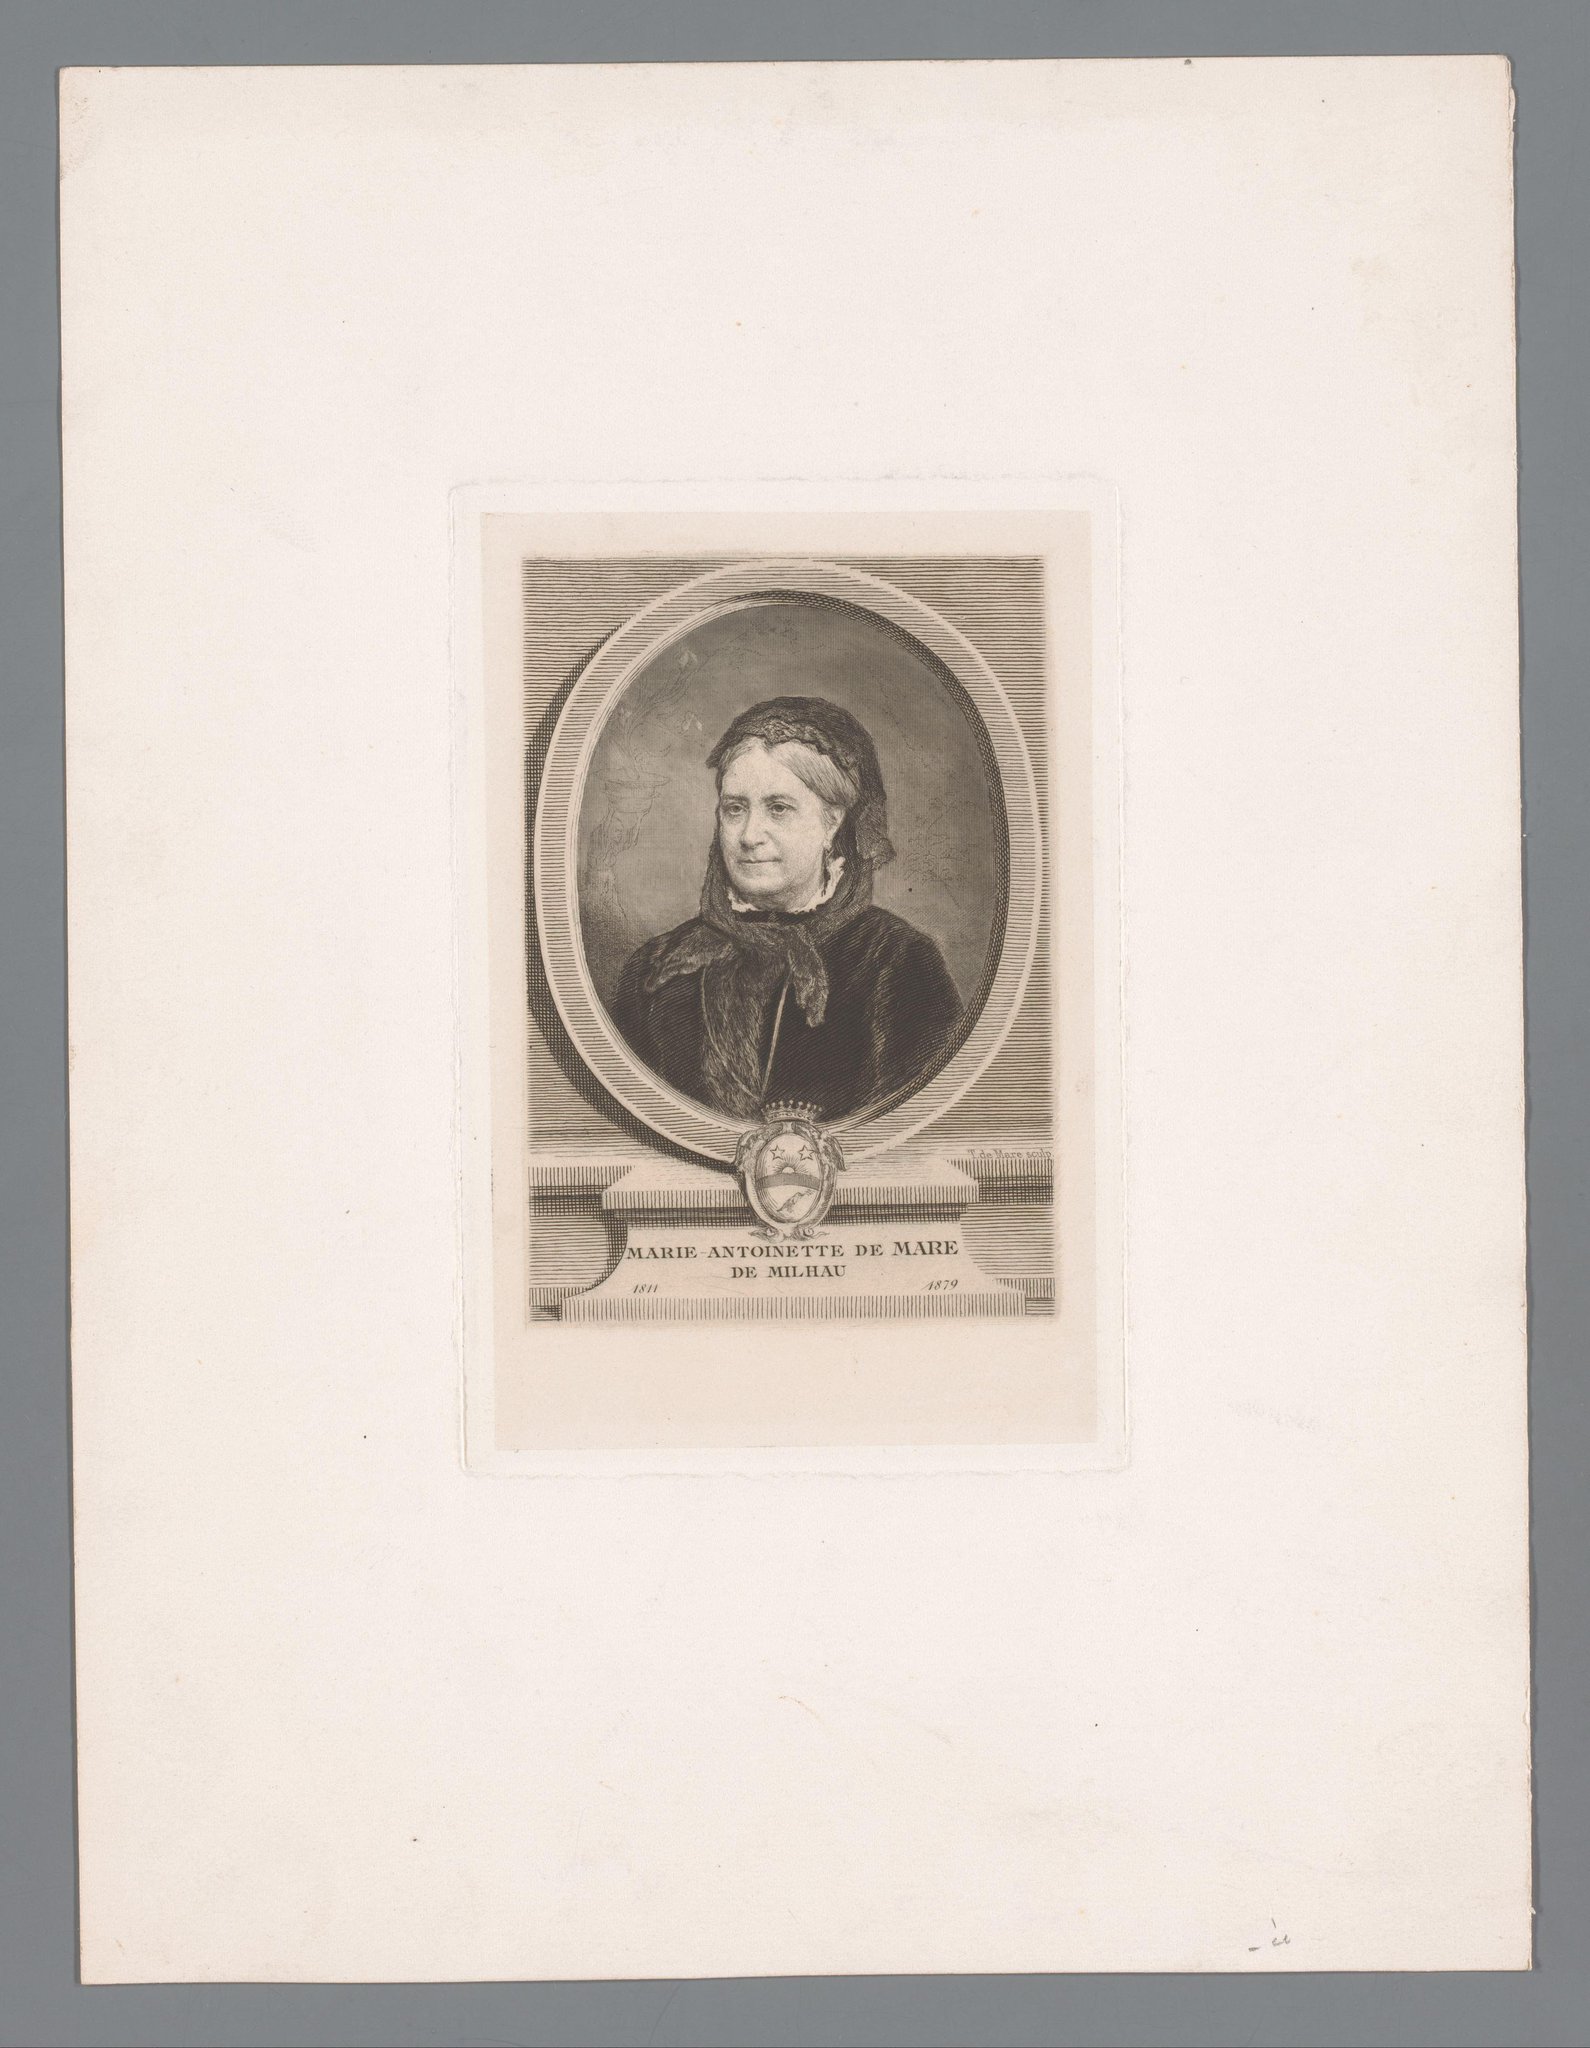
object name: print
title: Portret van Marie Antoinette de Milhau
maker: tiburce de mare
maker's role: print maker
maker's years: 1840-1900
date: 1850-1900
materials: paper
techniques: engraving, etching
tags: historical persons, old woman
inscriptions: collector's mark: Lugt 2228